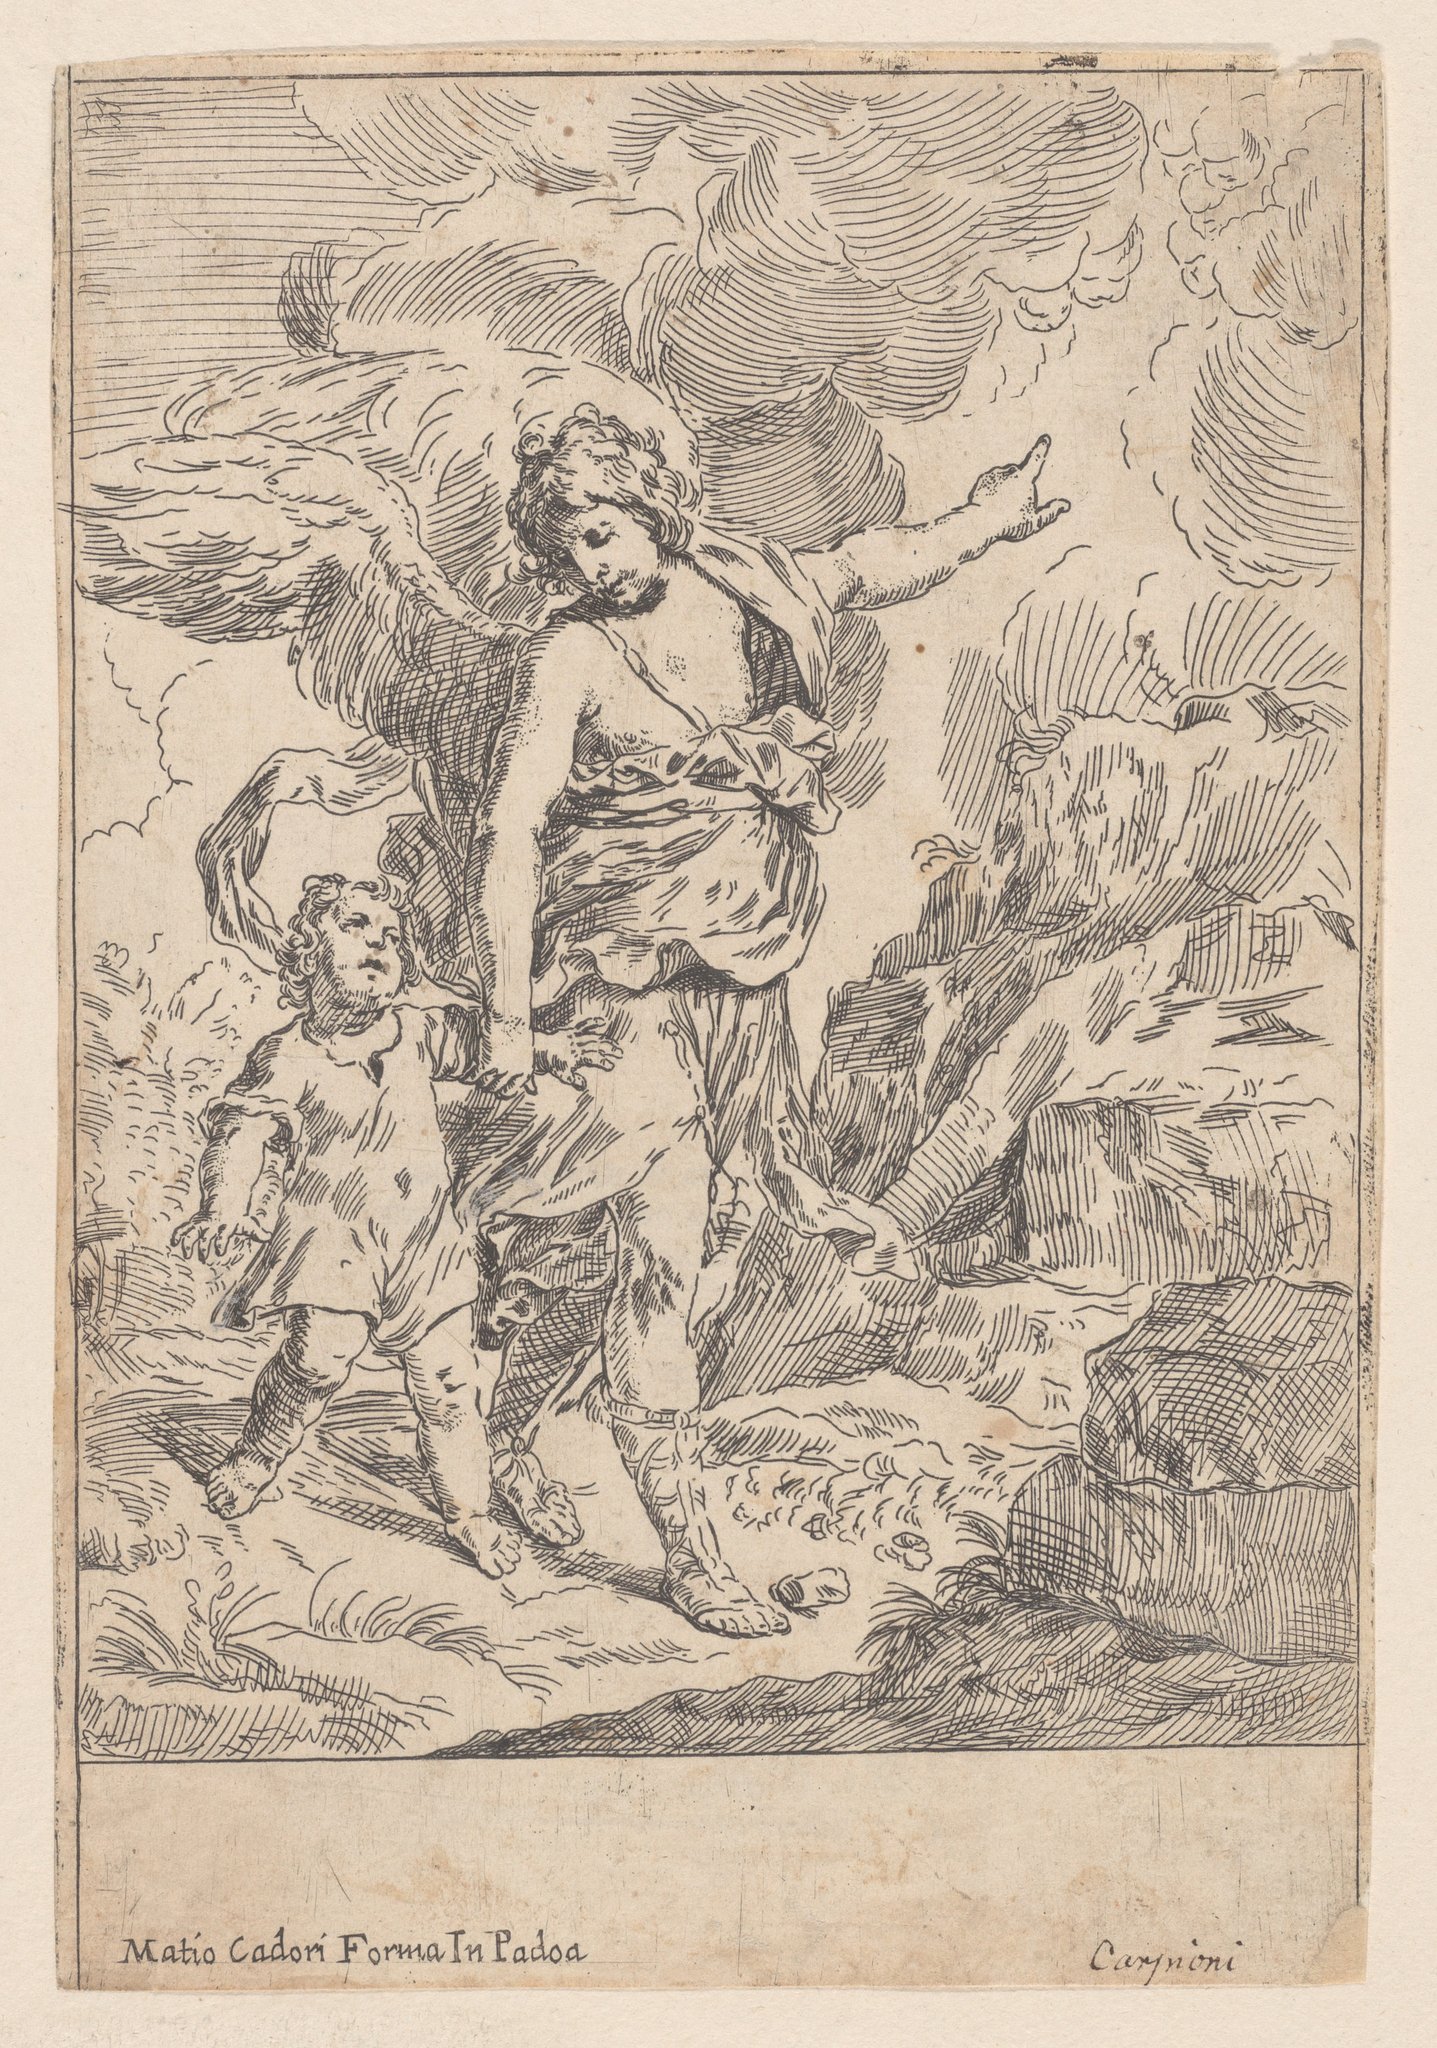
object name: print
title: A guardian angel walking hand in hand with a young child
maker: giulio carpioni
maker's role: artist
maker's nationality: italian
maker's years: 1613-1678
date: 1640-1660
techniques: etching